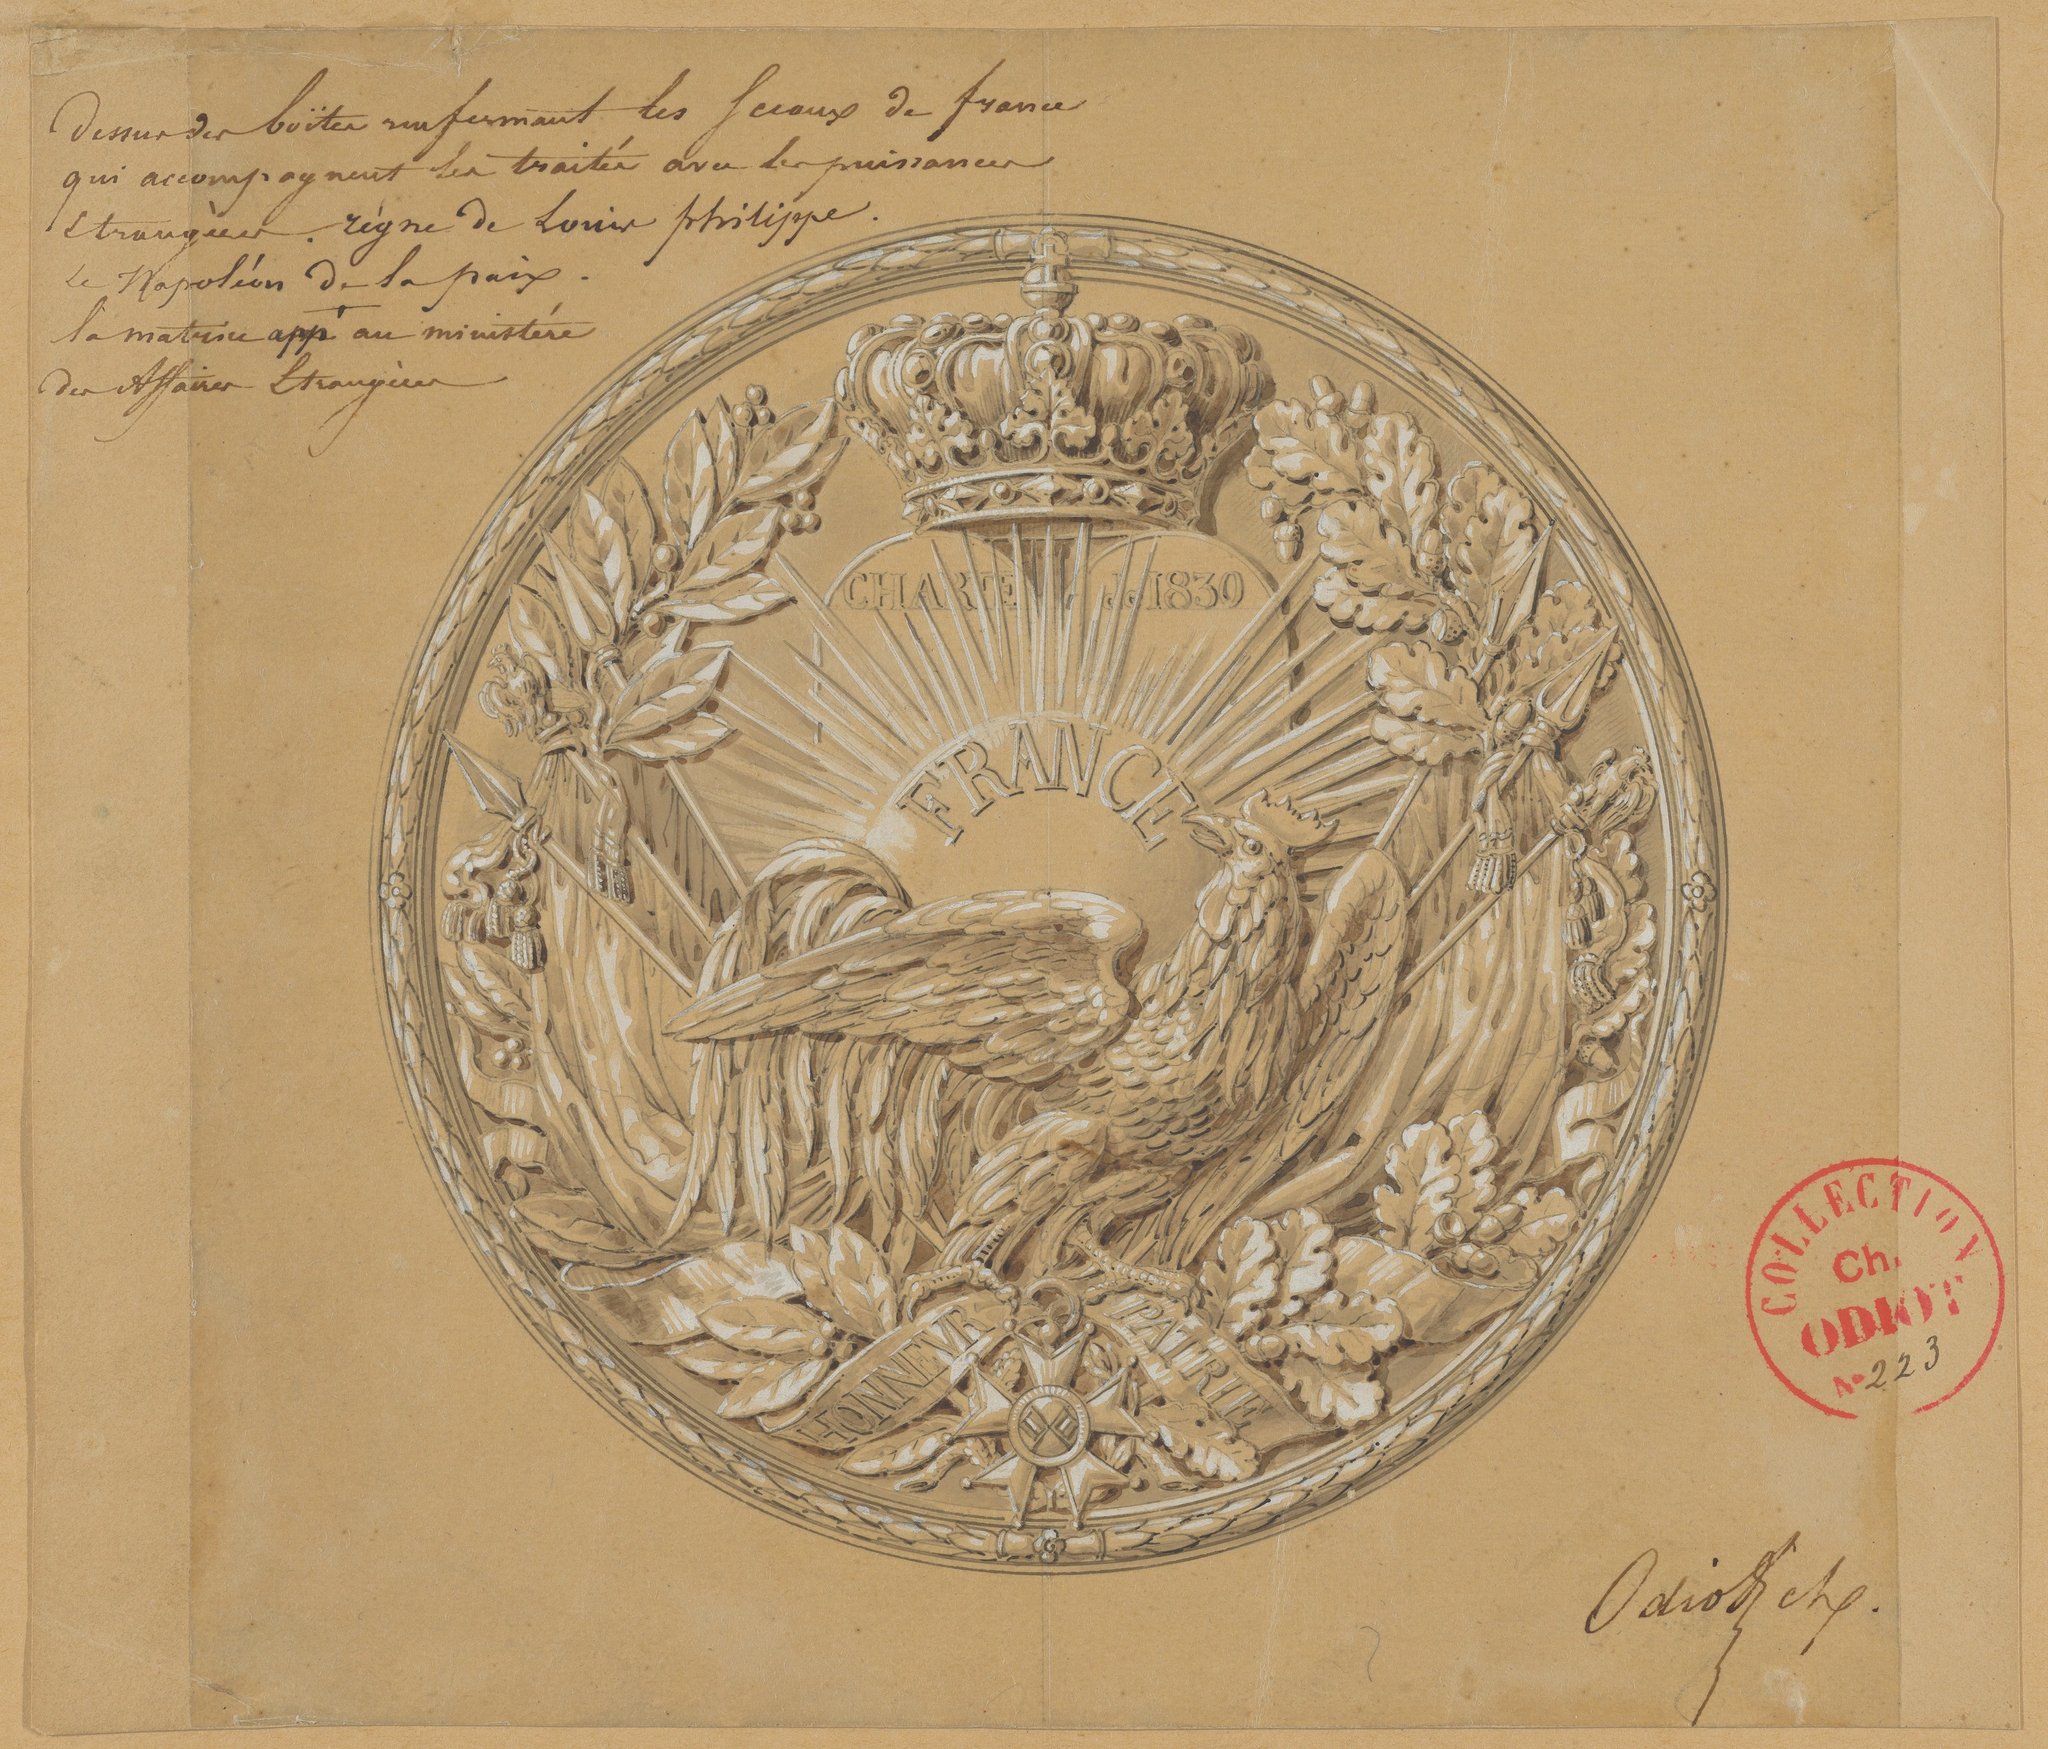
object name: drawing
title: Design for the Medal to Commemorate the Charter of 1830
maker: charles-nicolas odiot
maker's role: artist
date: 1830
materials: chalk, gouache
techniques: heightening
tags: eagles,insignia